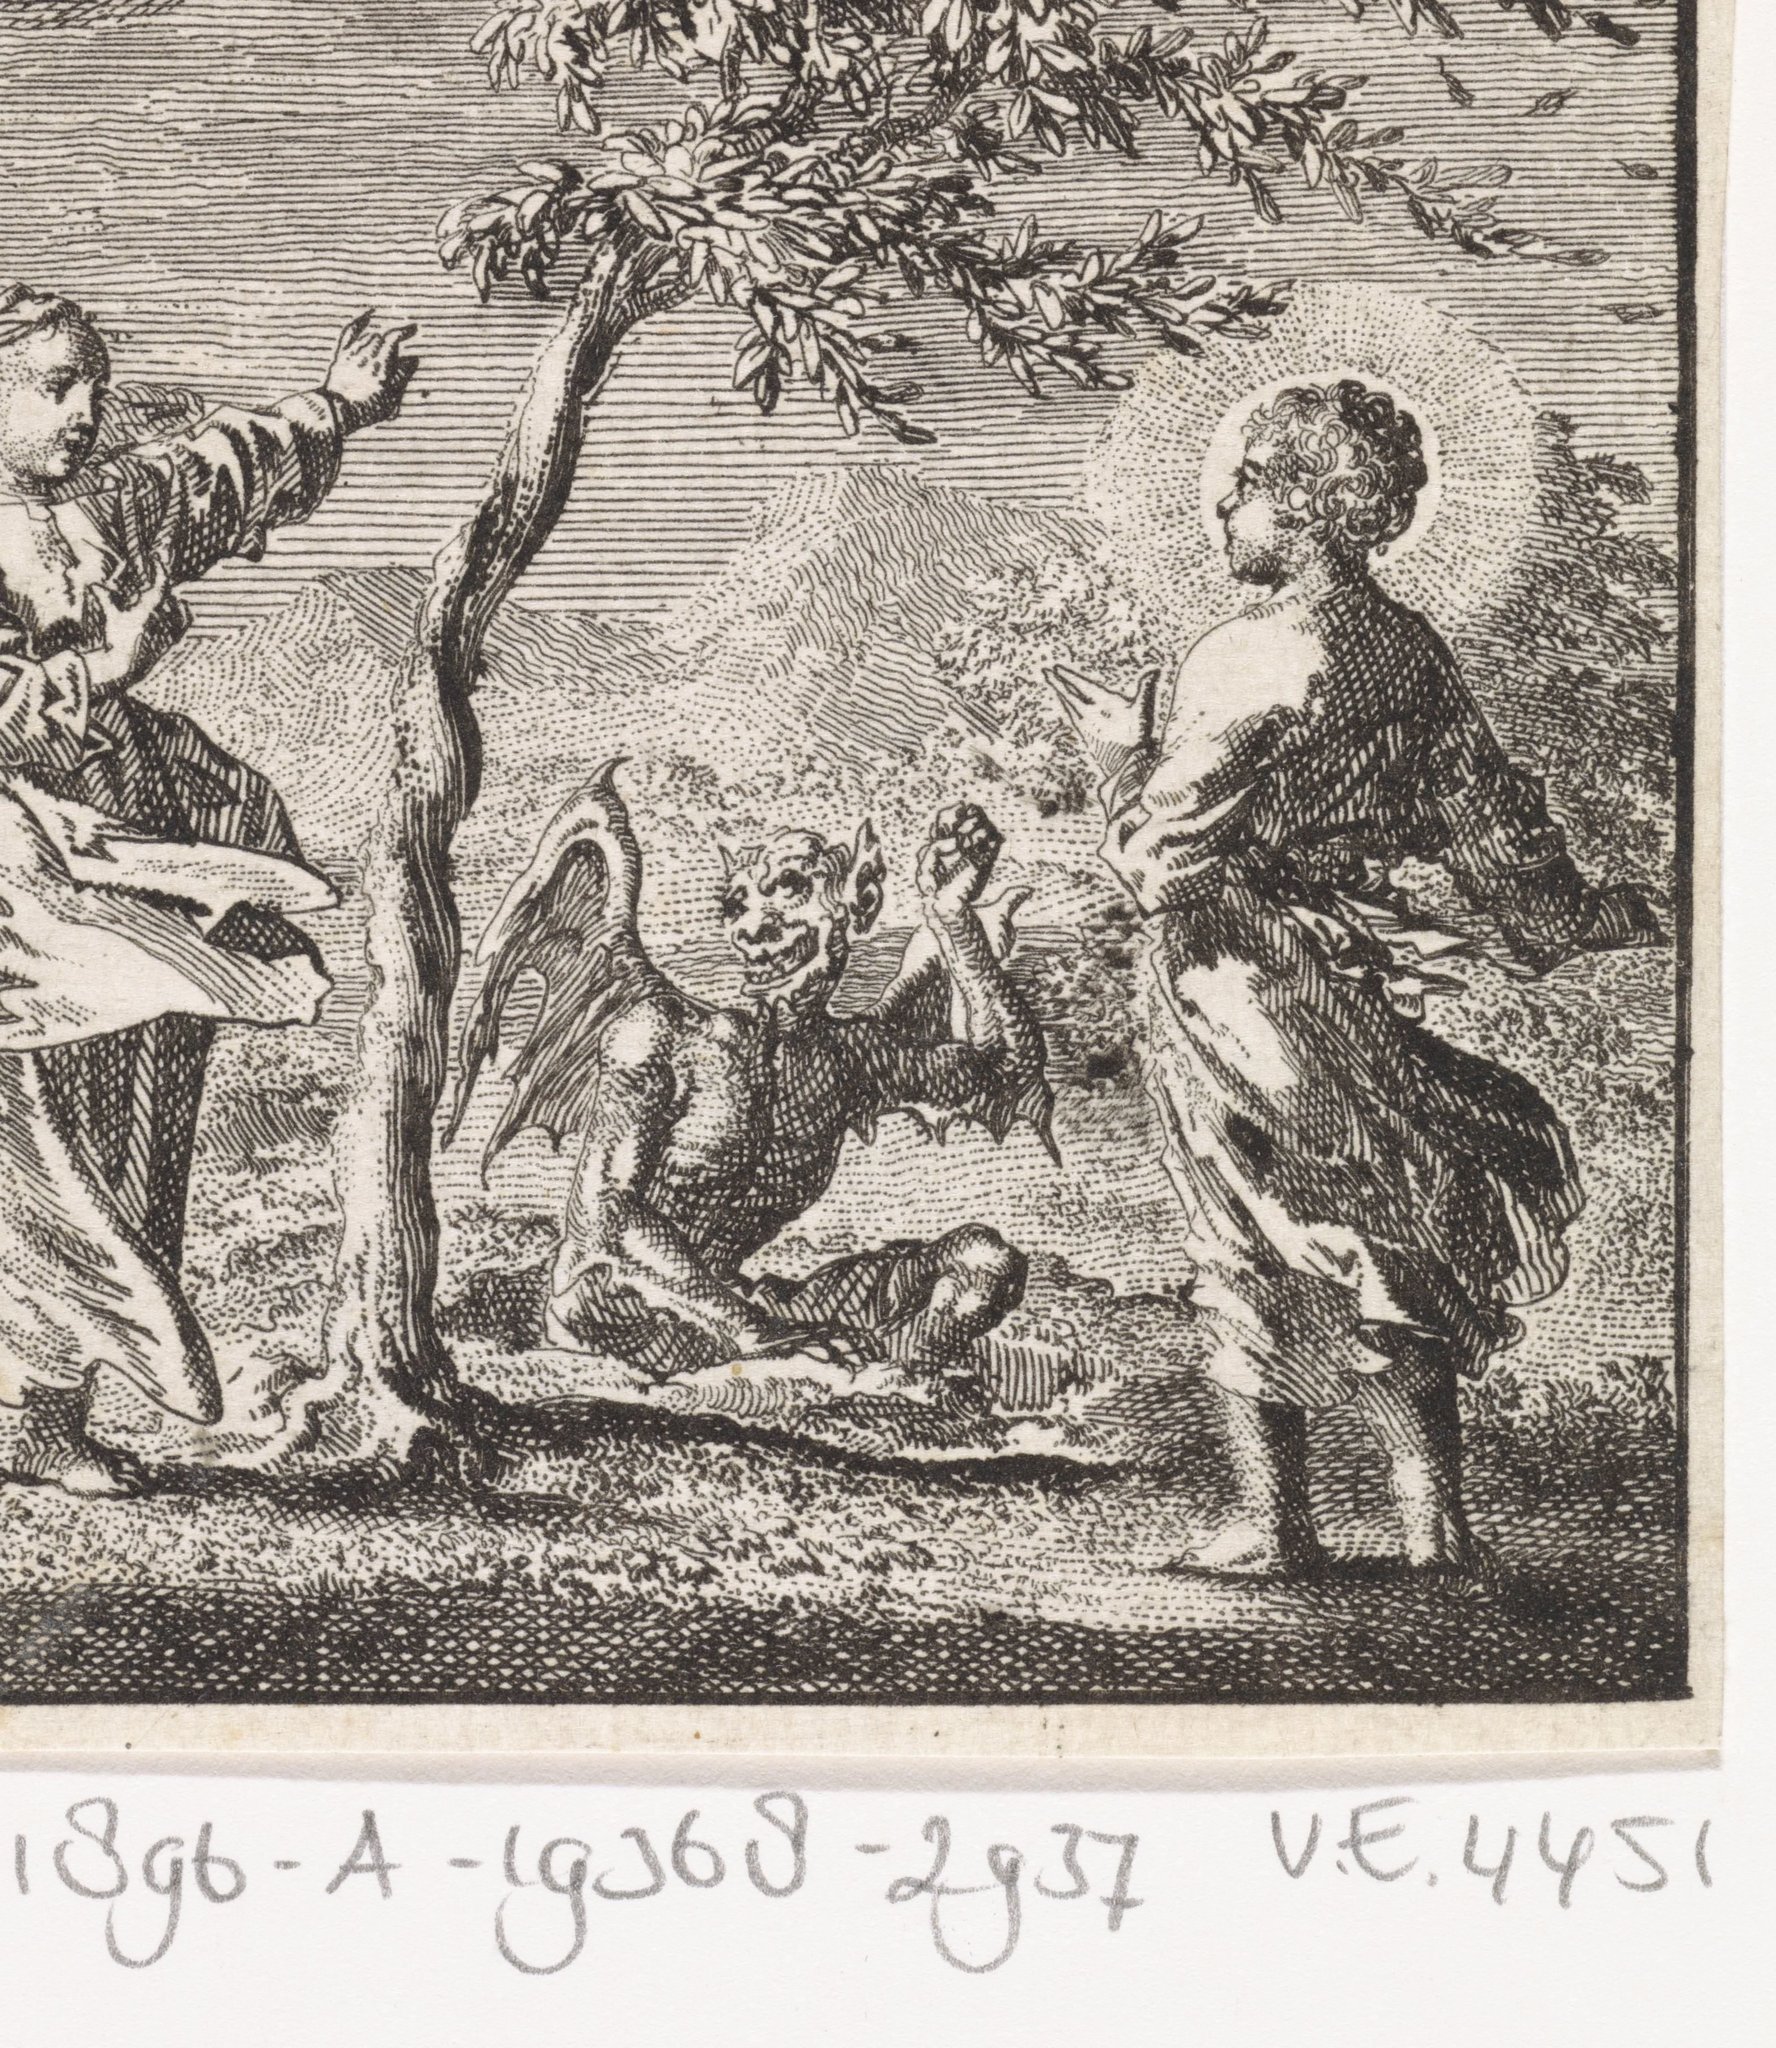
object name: print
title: Christus en de gepersonifieerde ziel in een storm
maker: jan luyken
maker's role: draughtsman, print maker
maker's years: 1649-1712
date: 1714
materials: paper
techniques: etching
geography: amsterdam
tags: christ and the soul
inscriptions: collector's mark: Lugt 2228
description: Proefdruk van illustratie uit: Luyken, Jan. Jezus en de Ziel, 3 delen. Amsterdam: Wed. Pieter Arentsz II en Cornelis van der Sys, 1714, dl. I, p. 51.